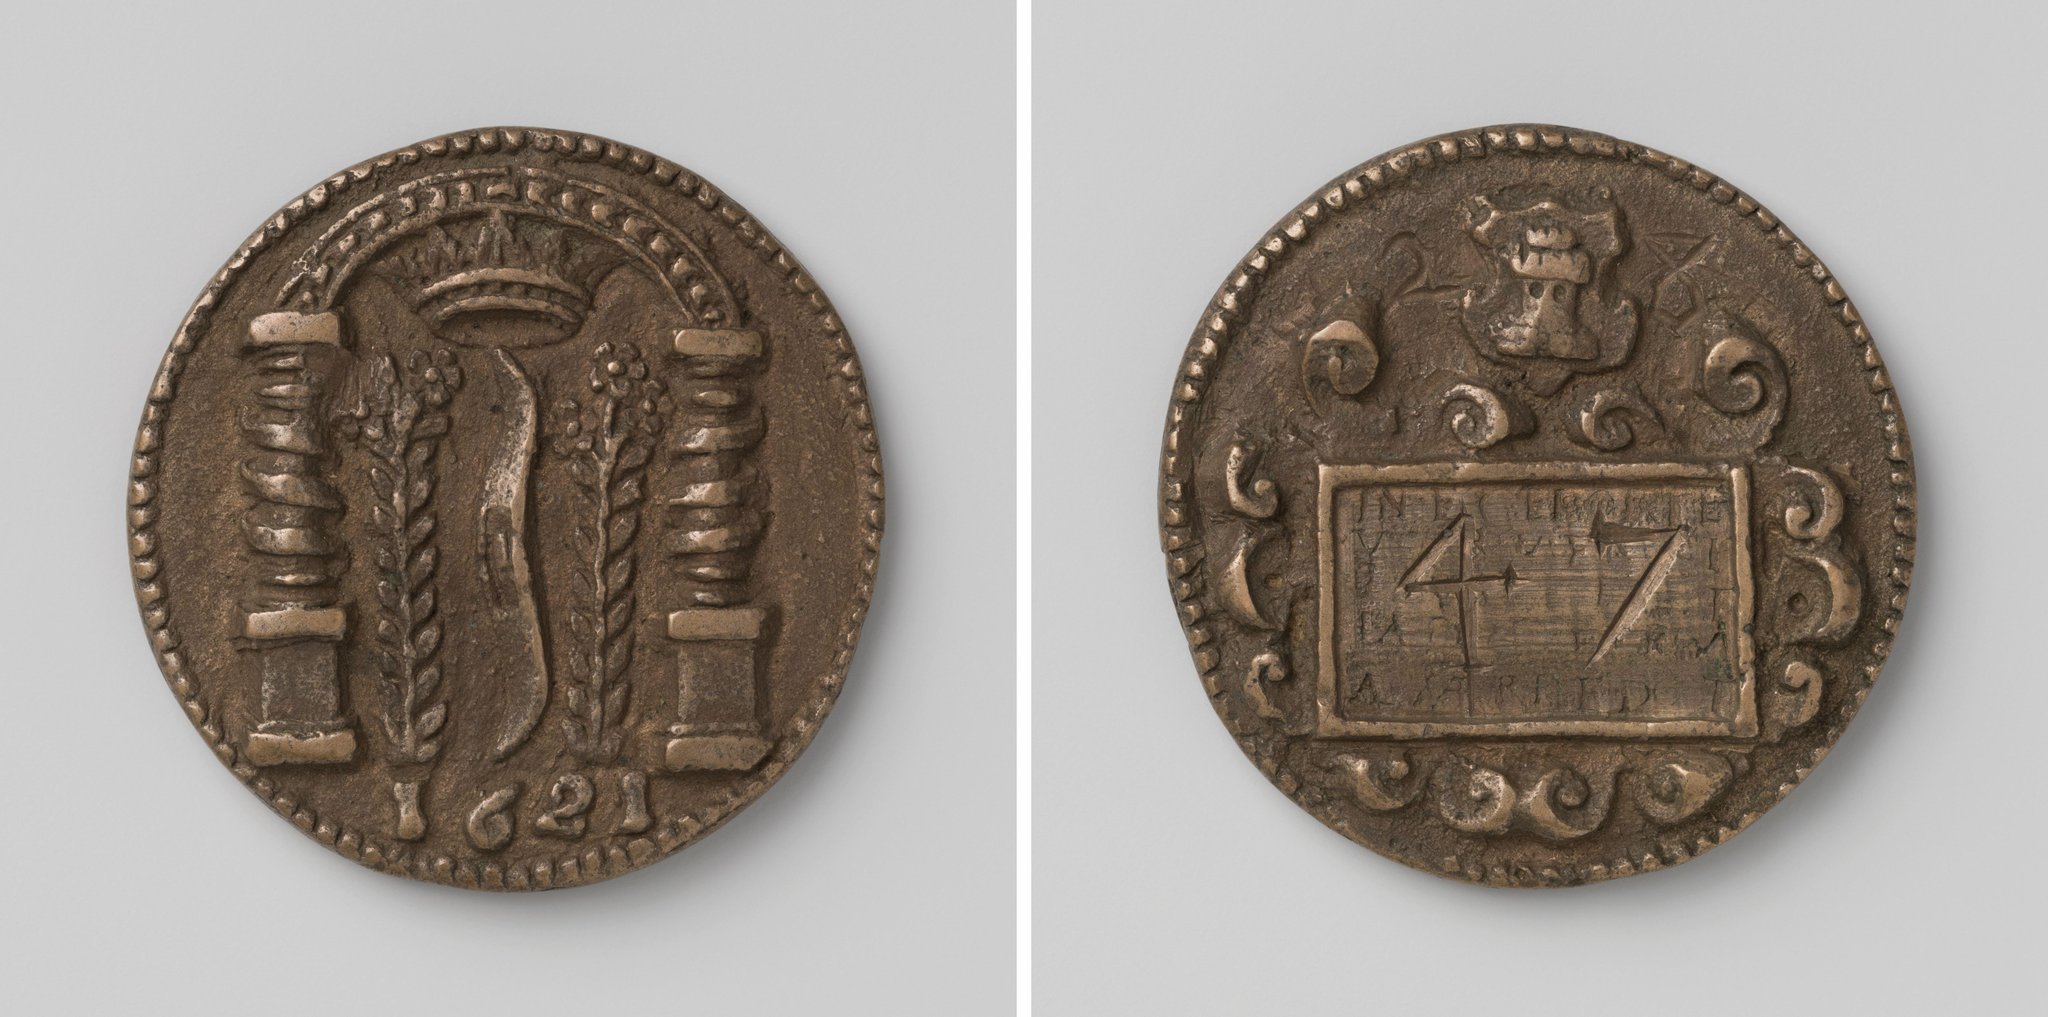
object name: medal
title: Weversgilde van Middelburg, gildepenning met no. 47 en no. 28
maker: Anonymous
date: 1621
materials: copper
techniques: casting, engraving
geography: middelburg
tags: middelburg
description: Koperen penning. Voorzijde: gekroonde, opstaande weversspoel tussen twee bloeiende vlasplanten boven jaartal onder een op twee gekroonde pilaren rustende boog. Keerzijde: wapenschild boven tableau met cijfer 47 in cartouche; aan weerszijden van het wapenschild: cijfers 2 en 8